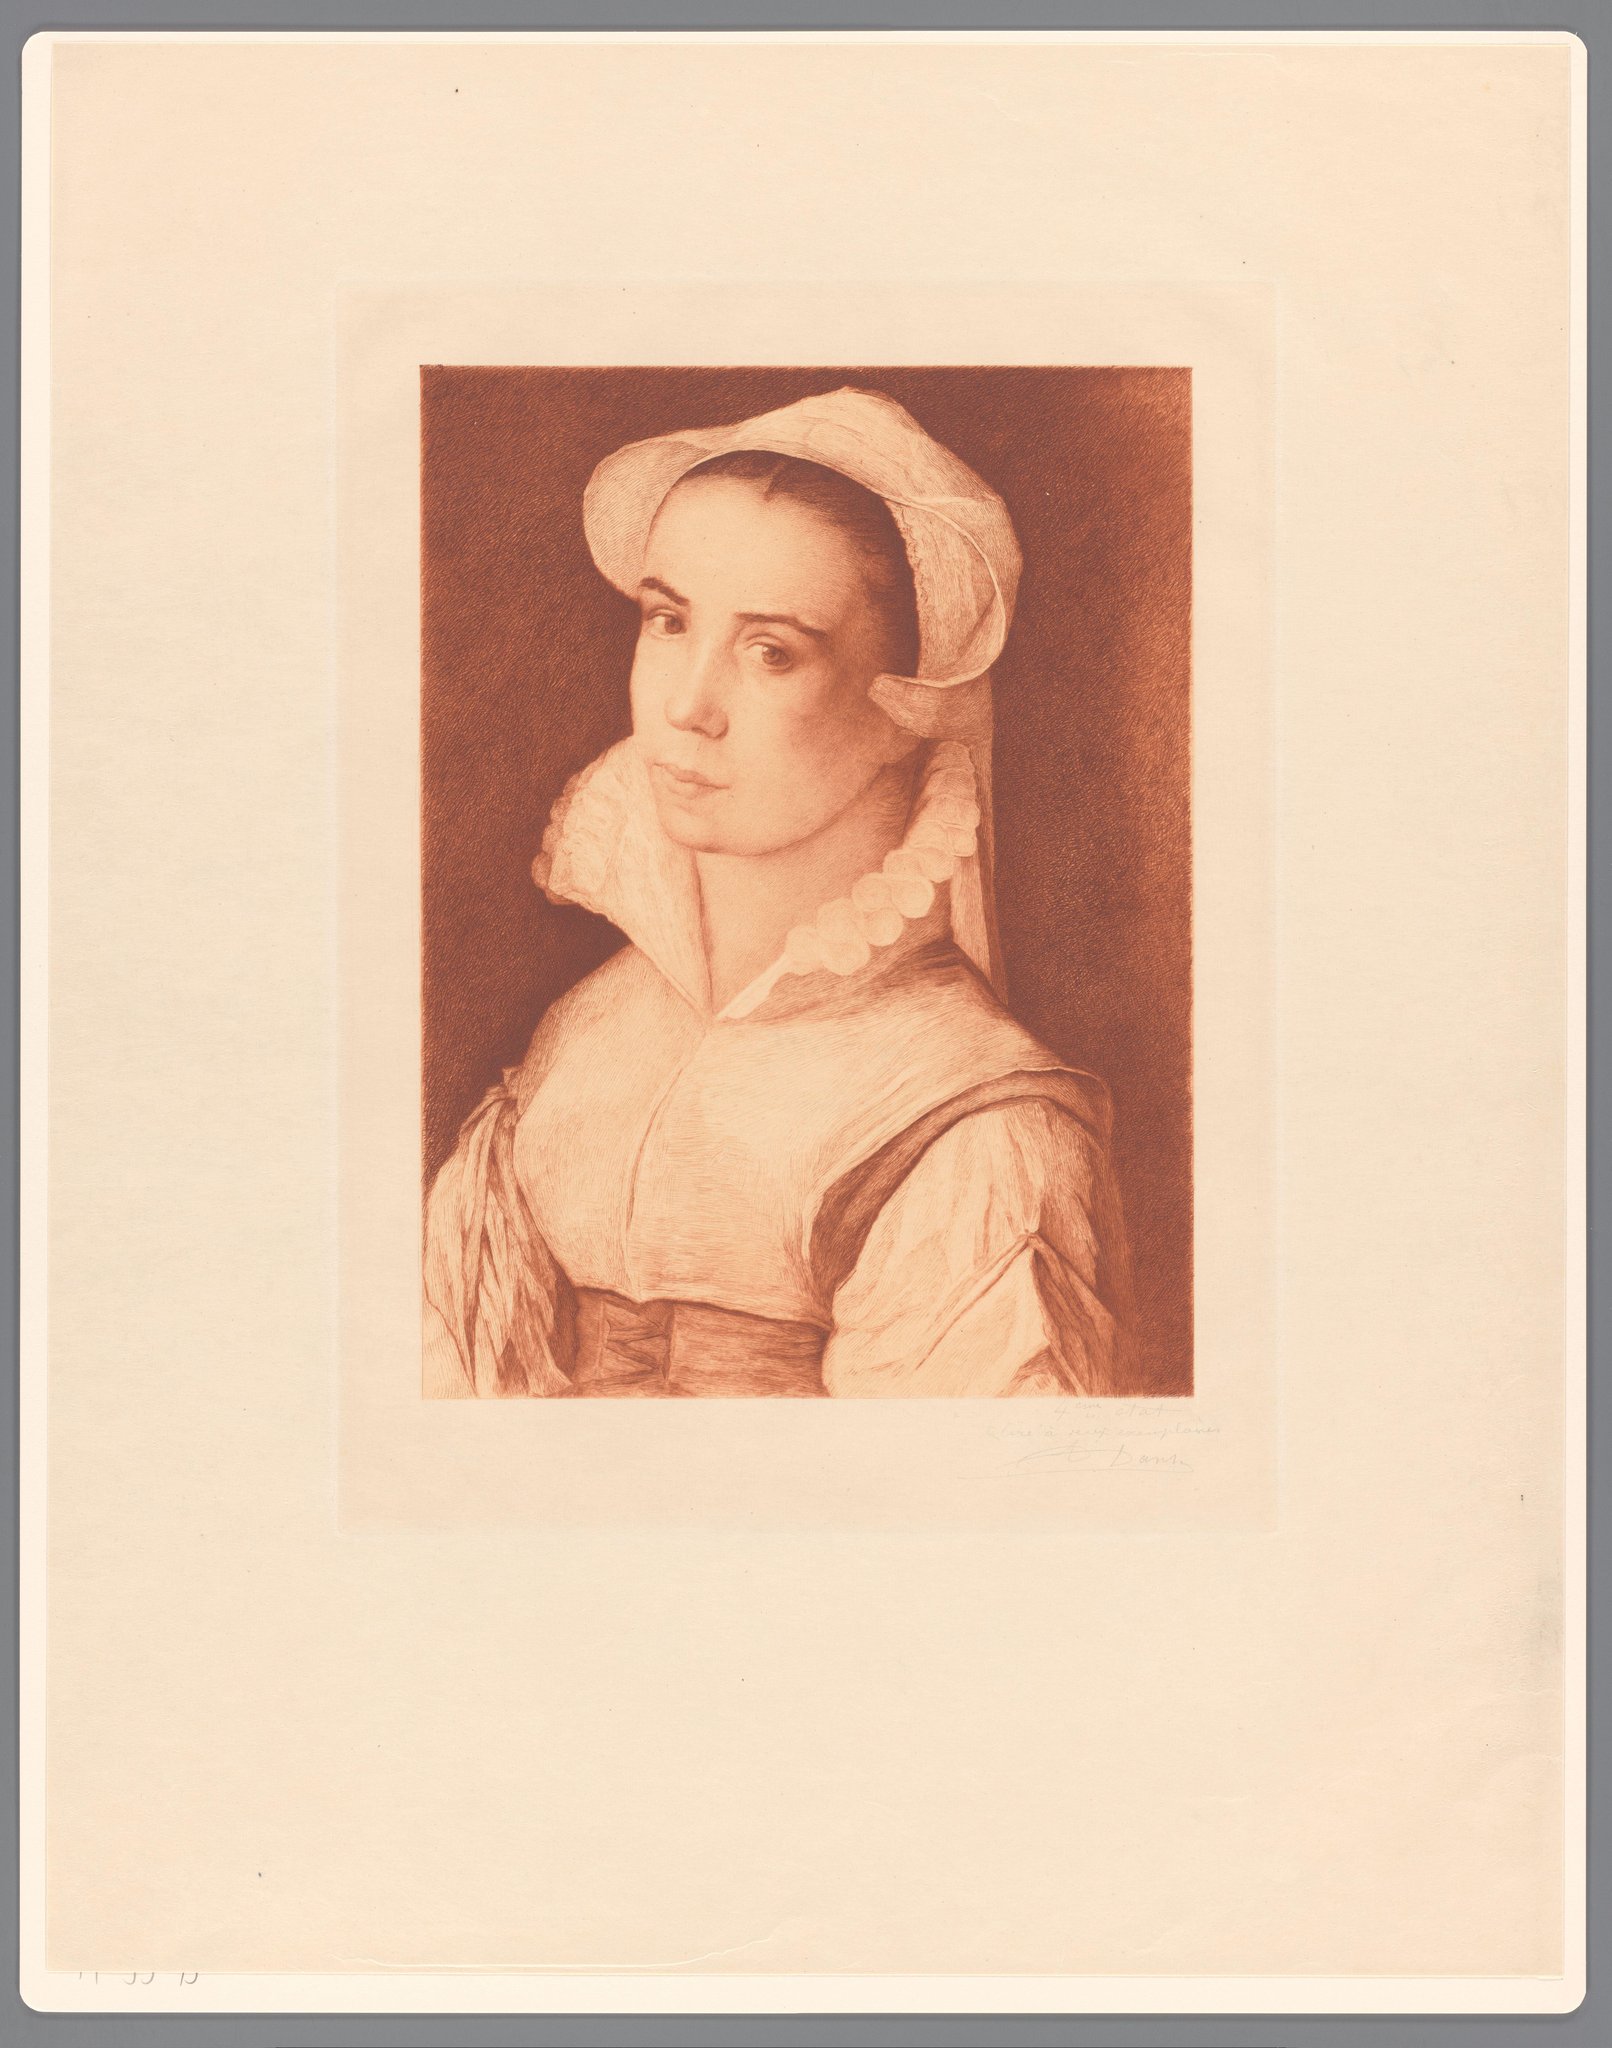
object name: print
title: Portret van een onbekende jonge vrouw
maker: auguste danse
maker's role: print maker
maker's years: 1829-1929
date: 1895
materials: paper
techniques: drypoint, etching, intaglio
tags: adolescent, young woman, maiden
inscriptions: collector's mark: Lugt 2228, annotation: ‘4eme état tiré à deux exemplaires’